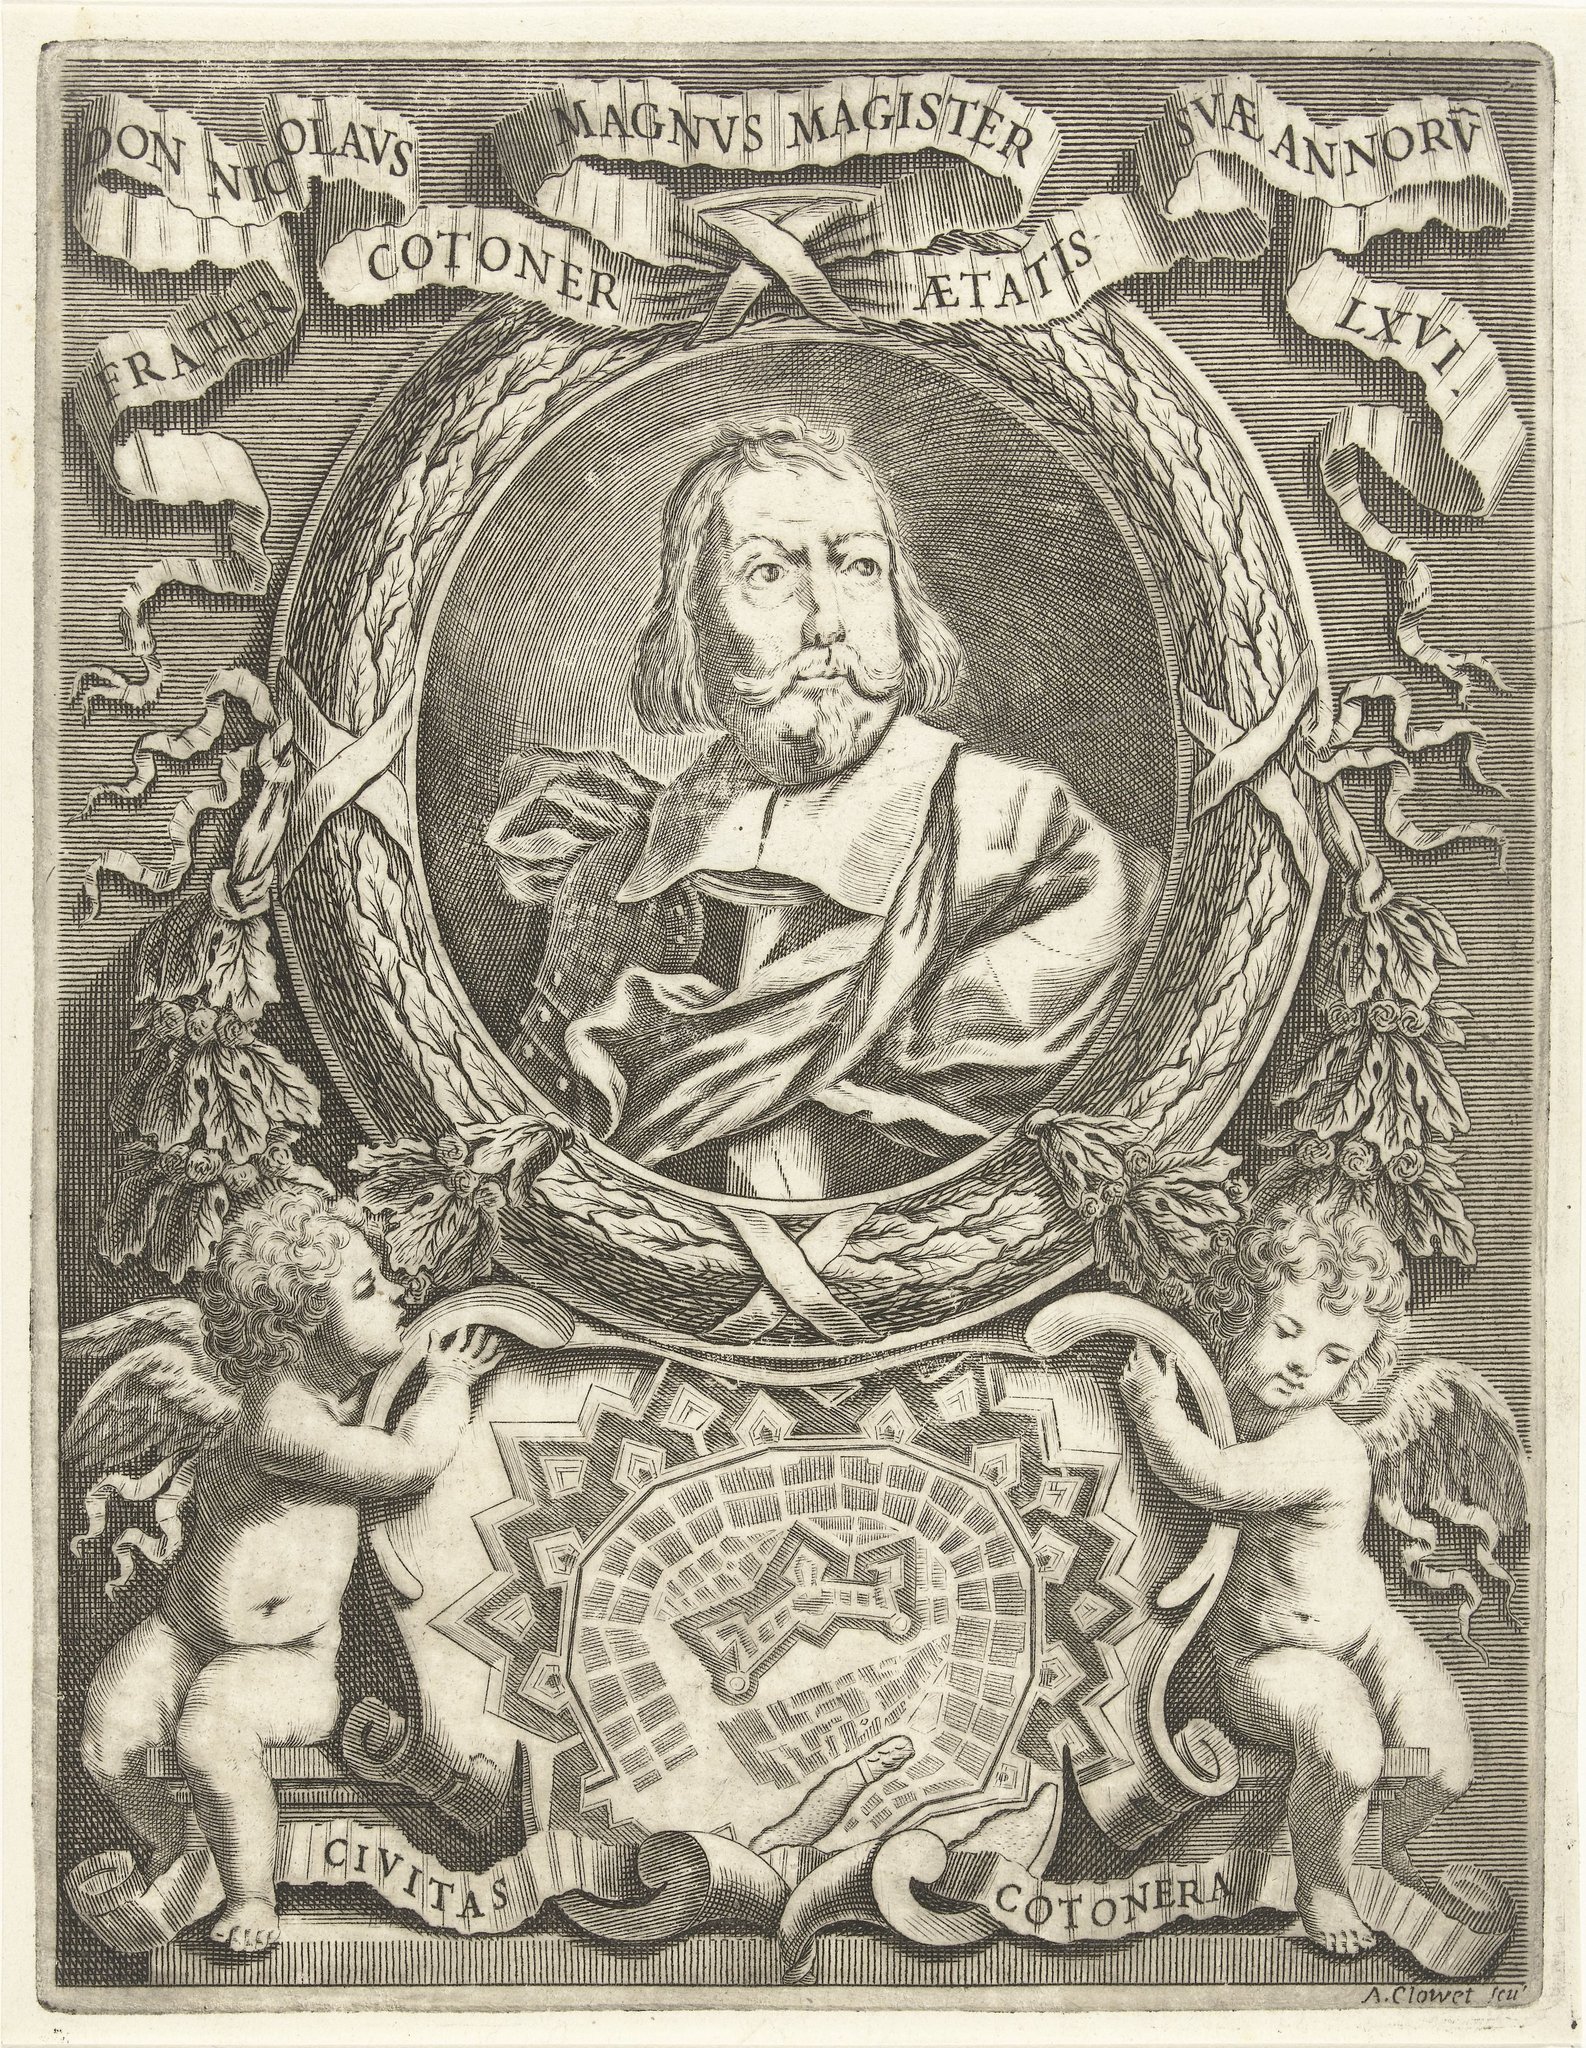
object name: print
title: Portret van Nicolás Cotoner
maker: albertus clouwet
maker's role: print maker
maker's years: 1636-1679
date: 1666-1679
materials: paper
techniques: engraving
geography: rome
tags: mallorca, malta, ridder, grootmeester, nicolás cotoner, valletta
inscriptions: collector's mark: Lugt 2228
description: Portret in ovale lijst van Nicolás Cotoner, grootmeester van de Malteser Orde. Buste naar rechts. Onderaan de prent houden twee engelen een cartouche omhoog met het plattegrond van de Sacra Infermeria in Valletta.